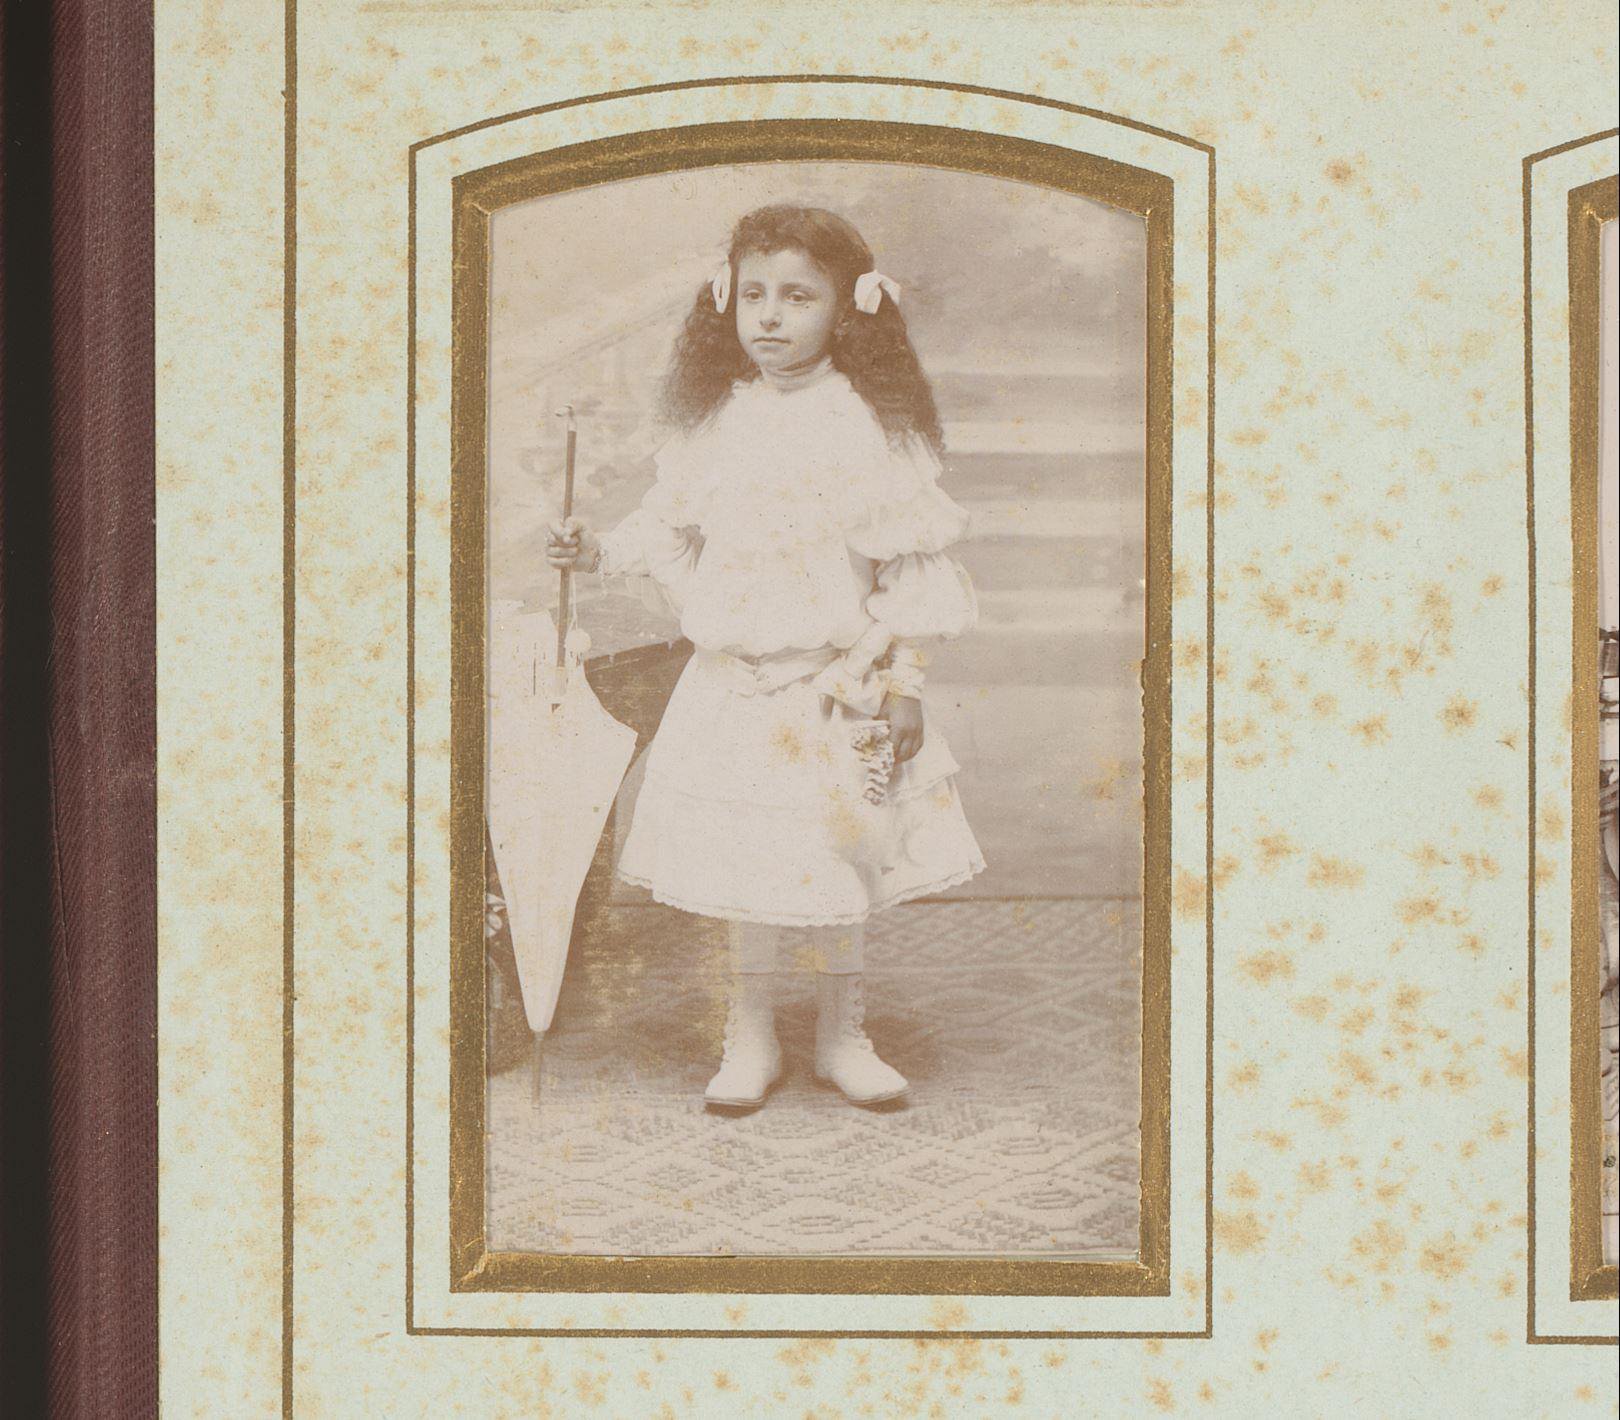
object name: carte de visite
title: Portret van een meisje met strikjes en paraplu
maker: Anonymous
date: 1880-1920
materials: cardboard, photographic support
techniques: gelatin silver print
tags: girl (child between toddler and youth)